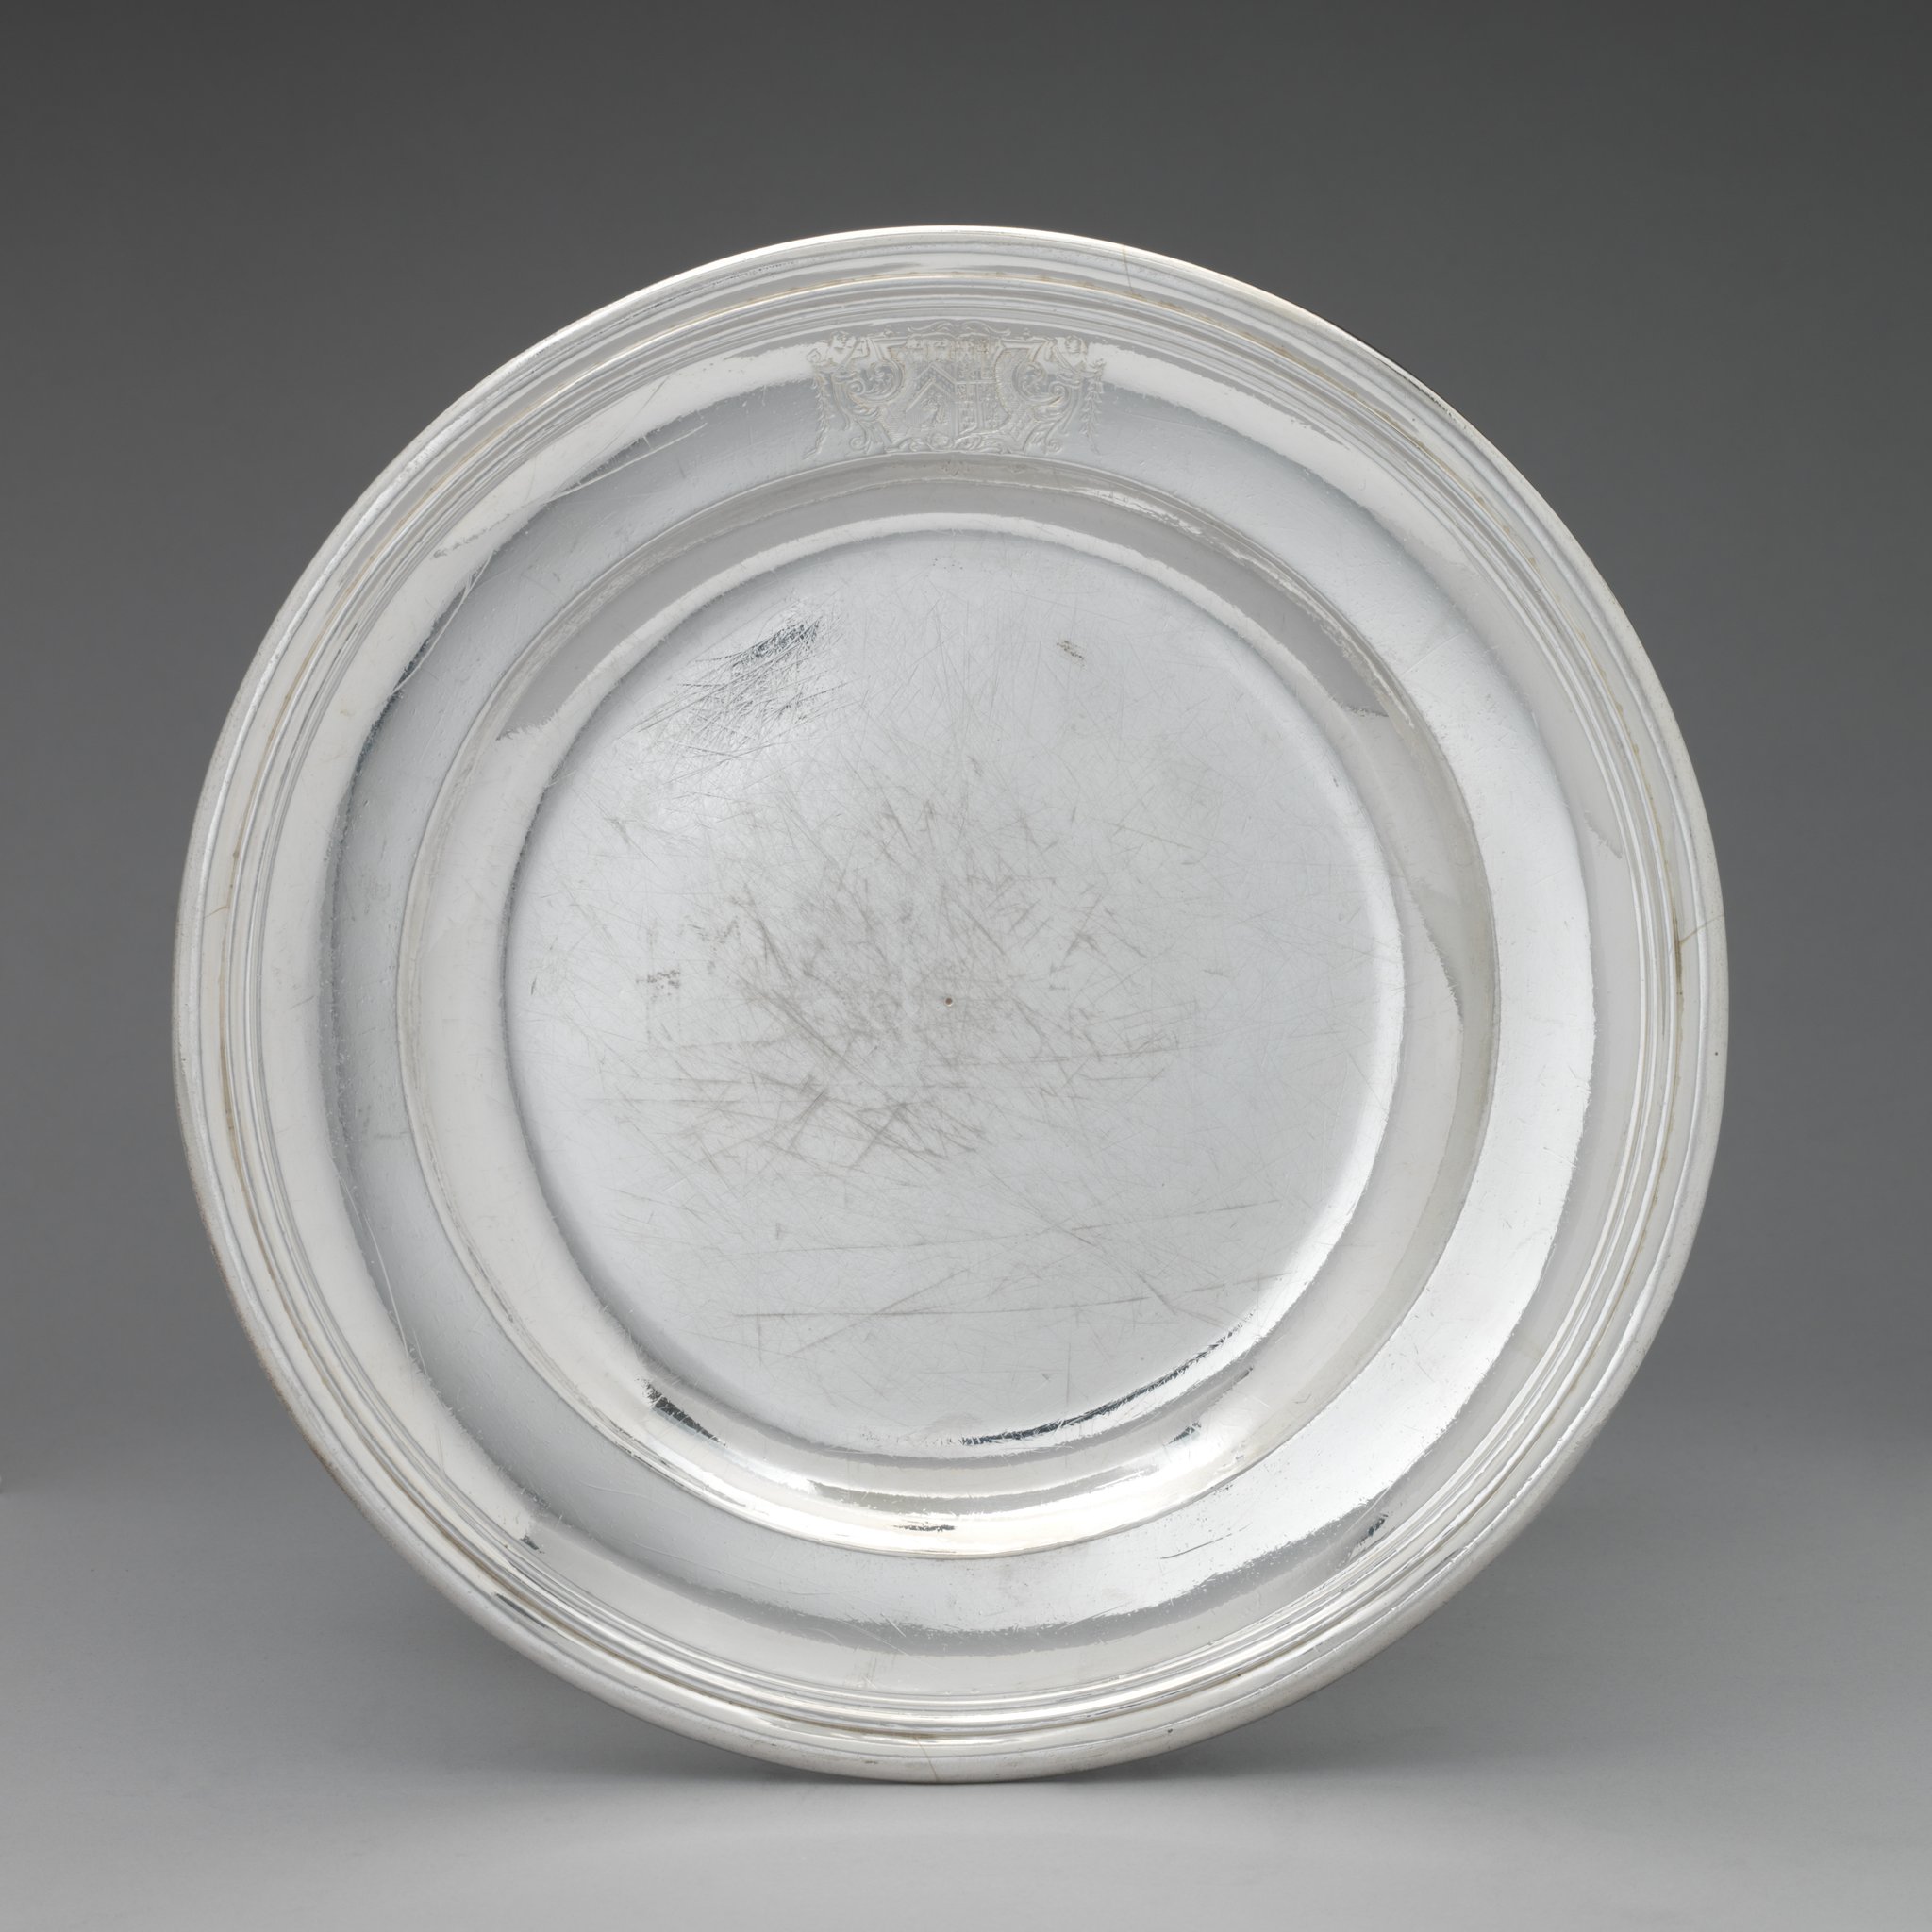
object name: plate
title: Plate (one of a set of twelve)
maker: thomas farren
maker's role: maker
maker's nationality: british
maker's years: 1703-1743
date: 1715-1716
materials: silver